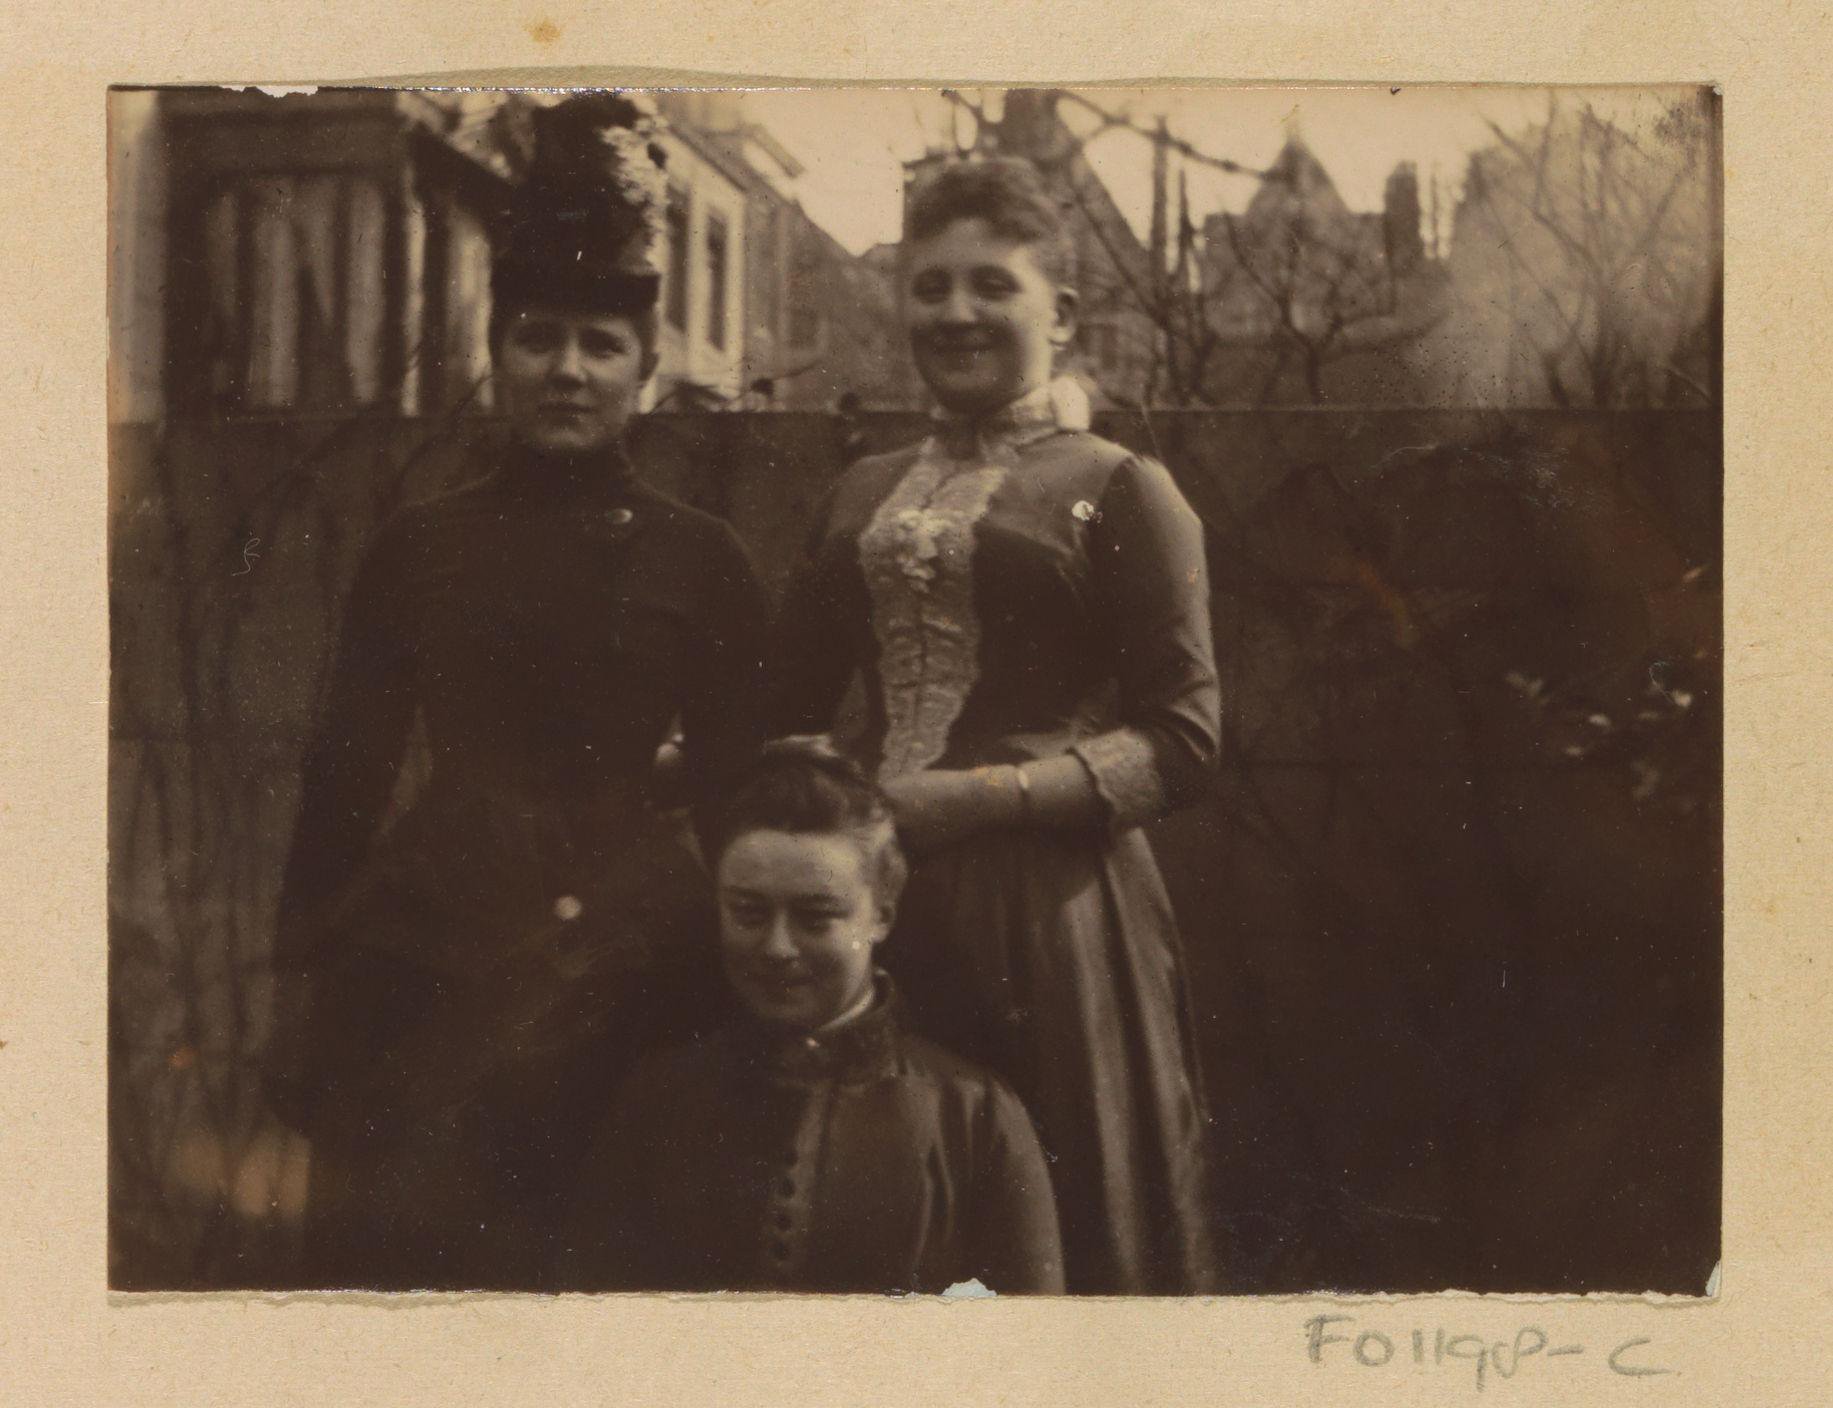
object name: album leaf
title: Groepsportret van Gesiena Piek, Louise Maria Fellinger en een onbekende vrouw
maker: johanna margaretha piek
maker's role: fotograaf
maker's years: 1870-1947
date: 1889-1893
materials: paper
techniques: gelatin silver print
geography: netherlands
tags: amsterdam, adult woman, anonymous historical persons portrayed in a group, in a group-portrait, netherlands